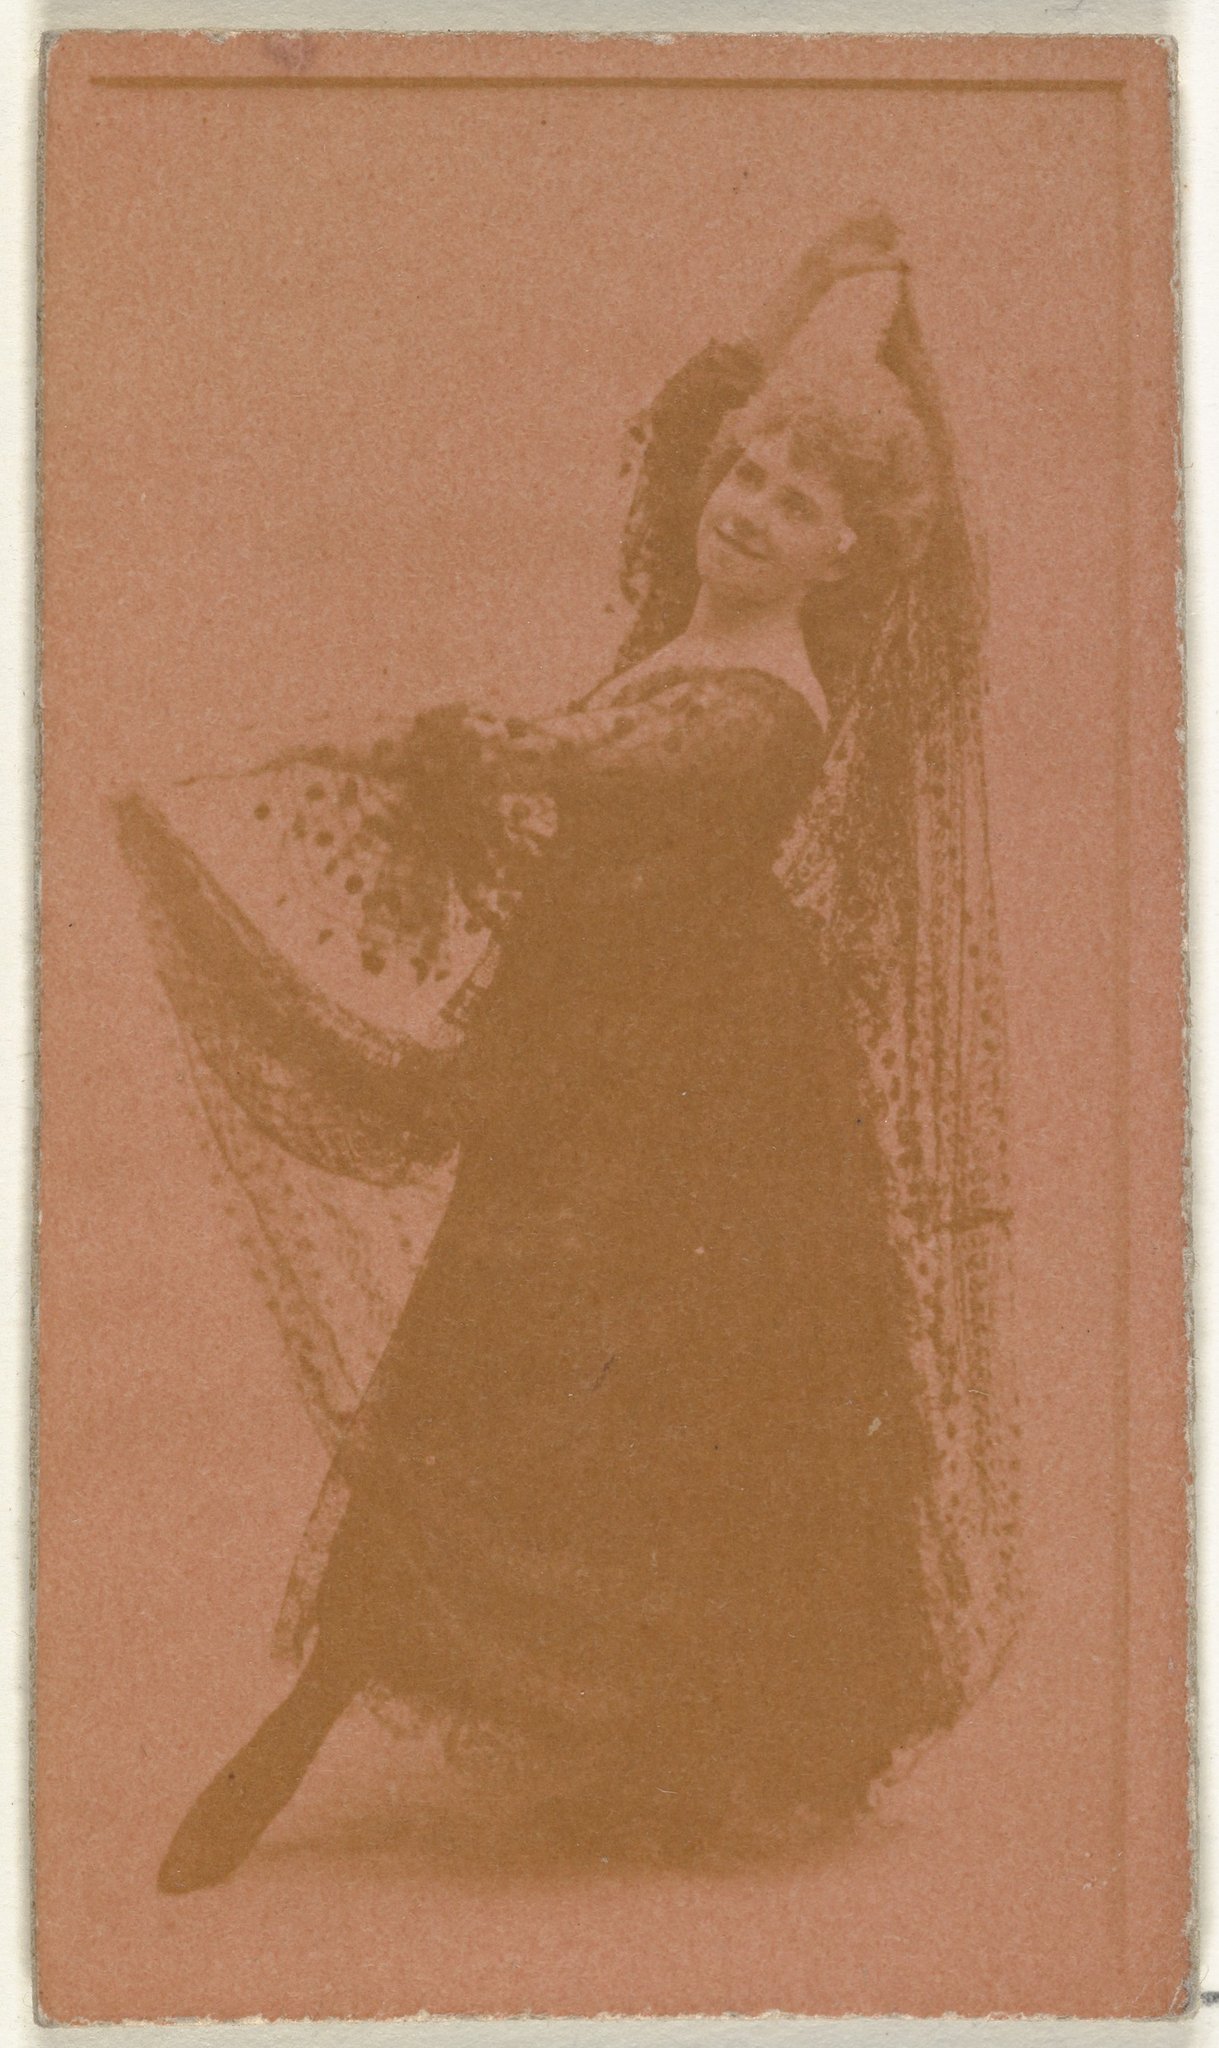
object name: photograph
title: [Dancer holding up veil], from the Actors and Actresses series (N145-8) issued by Duke Sons & Co. to promote Duke Cigarettes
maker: w. duke, sons & co.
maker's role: publisher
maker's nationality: american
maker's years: 1870-1920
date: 1891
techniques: albumen silver print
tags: portraits,women,dancing,actresses,dancers